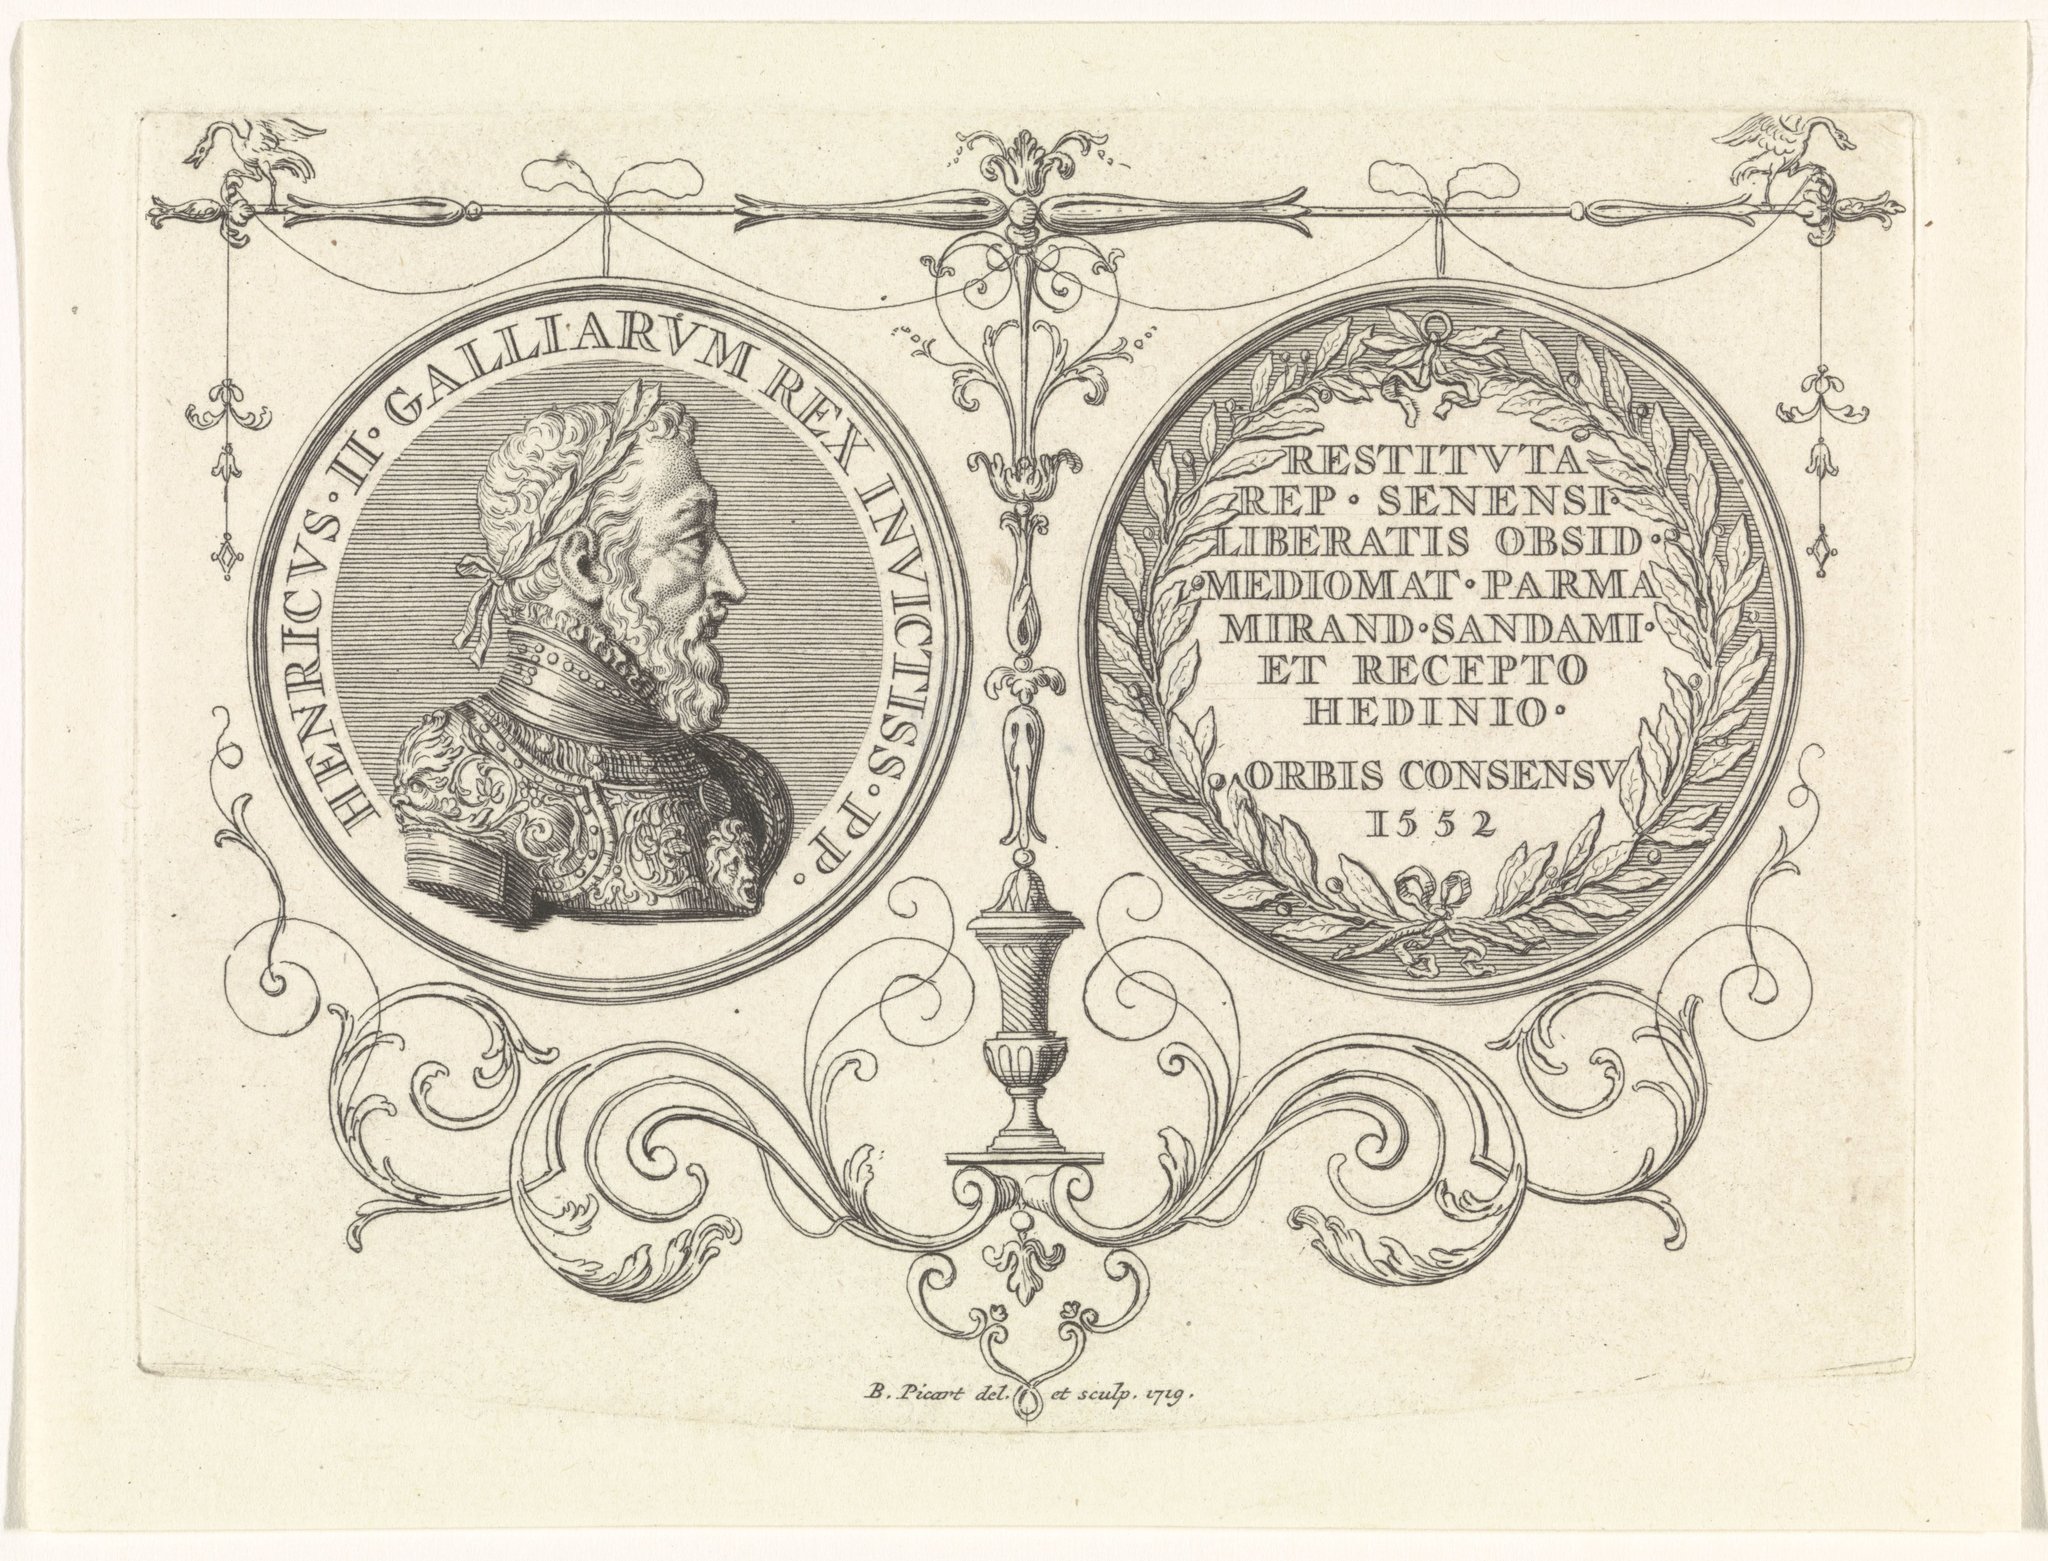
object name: print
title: Penning met het portret van Hendrik II, koning van Frankrijk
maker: bernard picart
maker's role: draughtsman, print maker, publisher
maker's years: 1673-1733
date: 1719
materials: paper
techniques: engraving, etching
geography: amsterdam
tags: paris, scrollwork, strapwork ~ ornament, medal (considered as a piece of sculpture, regardless of its specific function)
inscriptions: collector's mark: Lugt 2233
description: Penning met het portret van Hendrik II, koning van Frankrijk. Op de andere zijde een tekst in het Latijn. Met een ornamentele omlijsting.